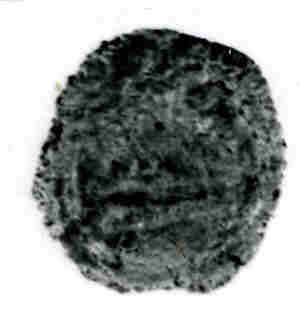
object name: coin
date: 701-900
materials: copper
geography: iran